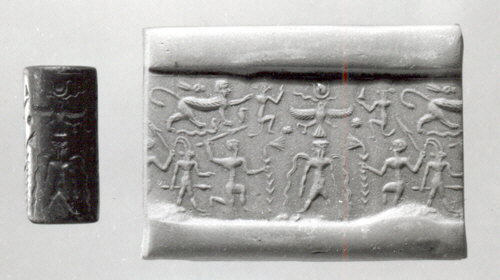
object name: cylinder seal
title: Cylinder seal and modern impression: bearded deity flanked by kneeling heroes; Horus and monkeys; ibex-demon; sphinx trampling serpents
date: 1900-1801 BCE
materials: mineral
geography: syria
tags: horus,sphinx,monkeys,demons